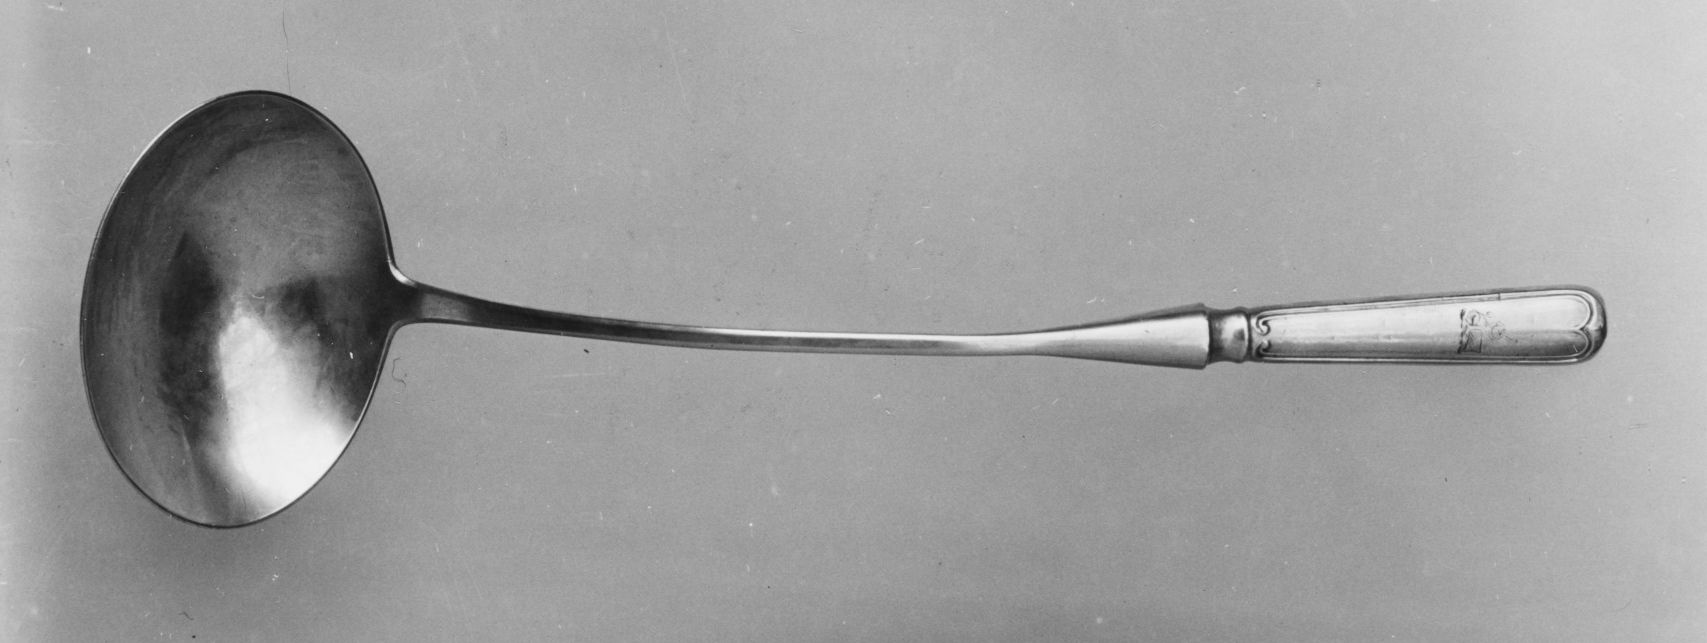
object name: ladle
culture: american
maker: william cleveland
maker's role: maker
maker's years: 1770-1837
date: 1815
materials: silver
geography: united states